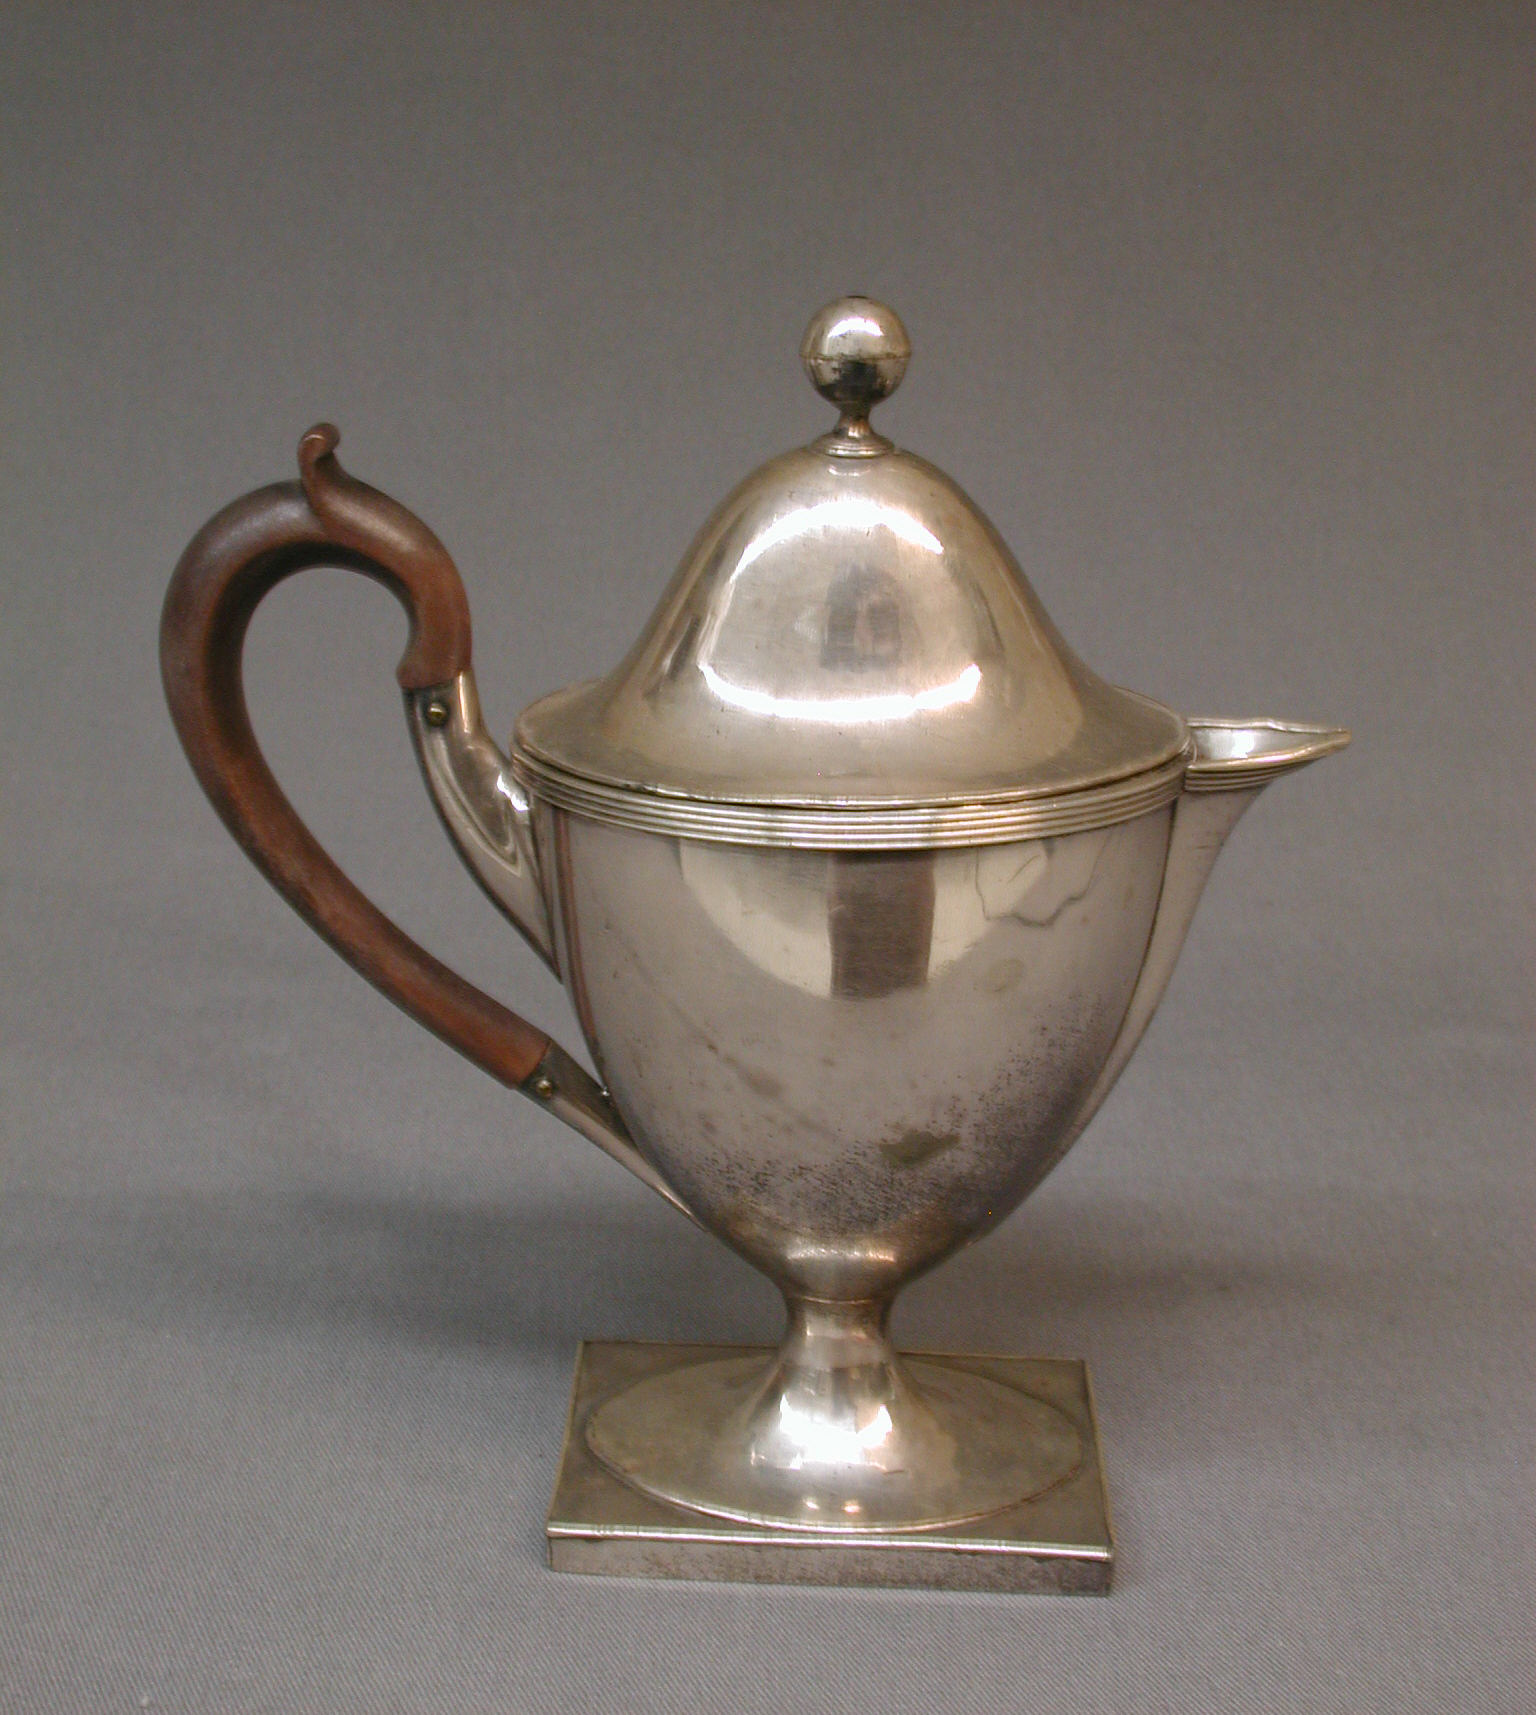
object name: argyle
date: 1790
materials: metal, wood